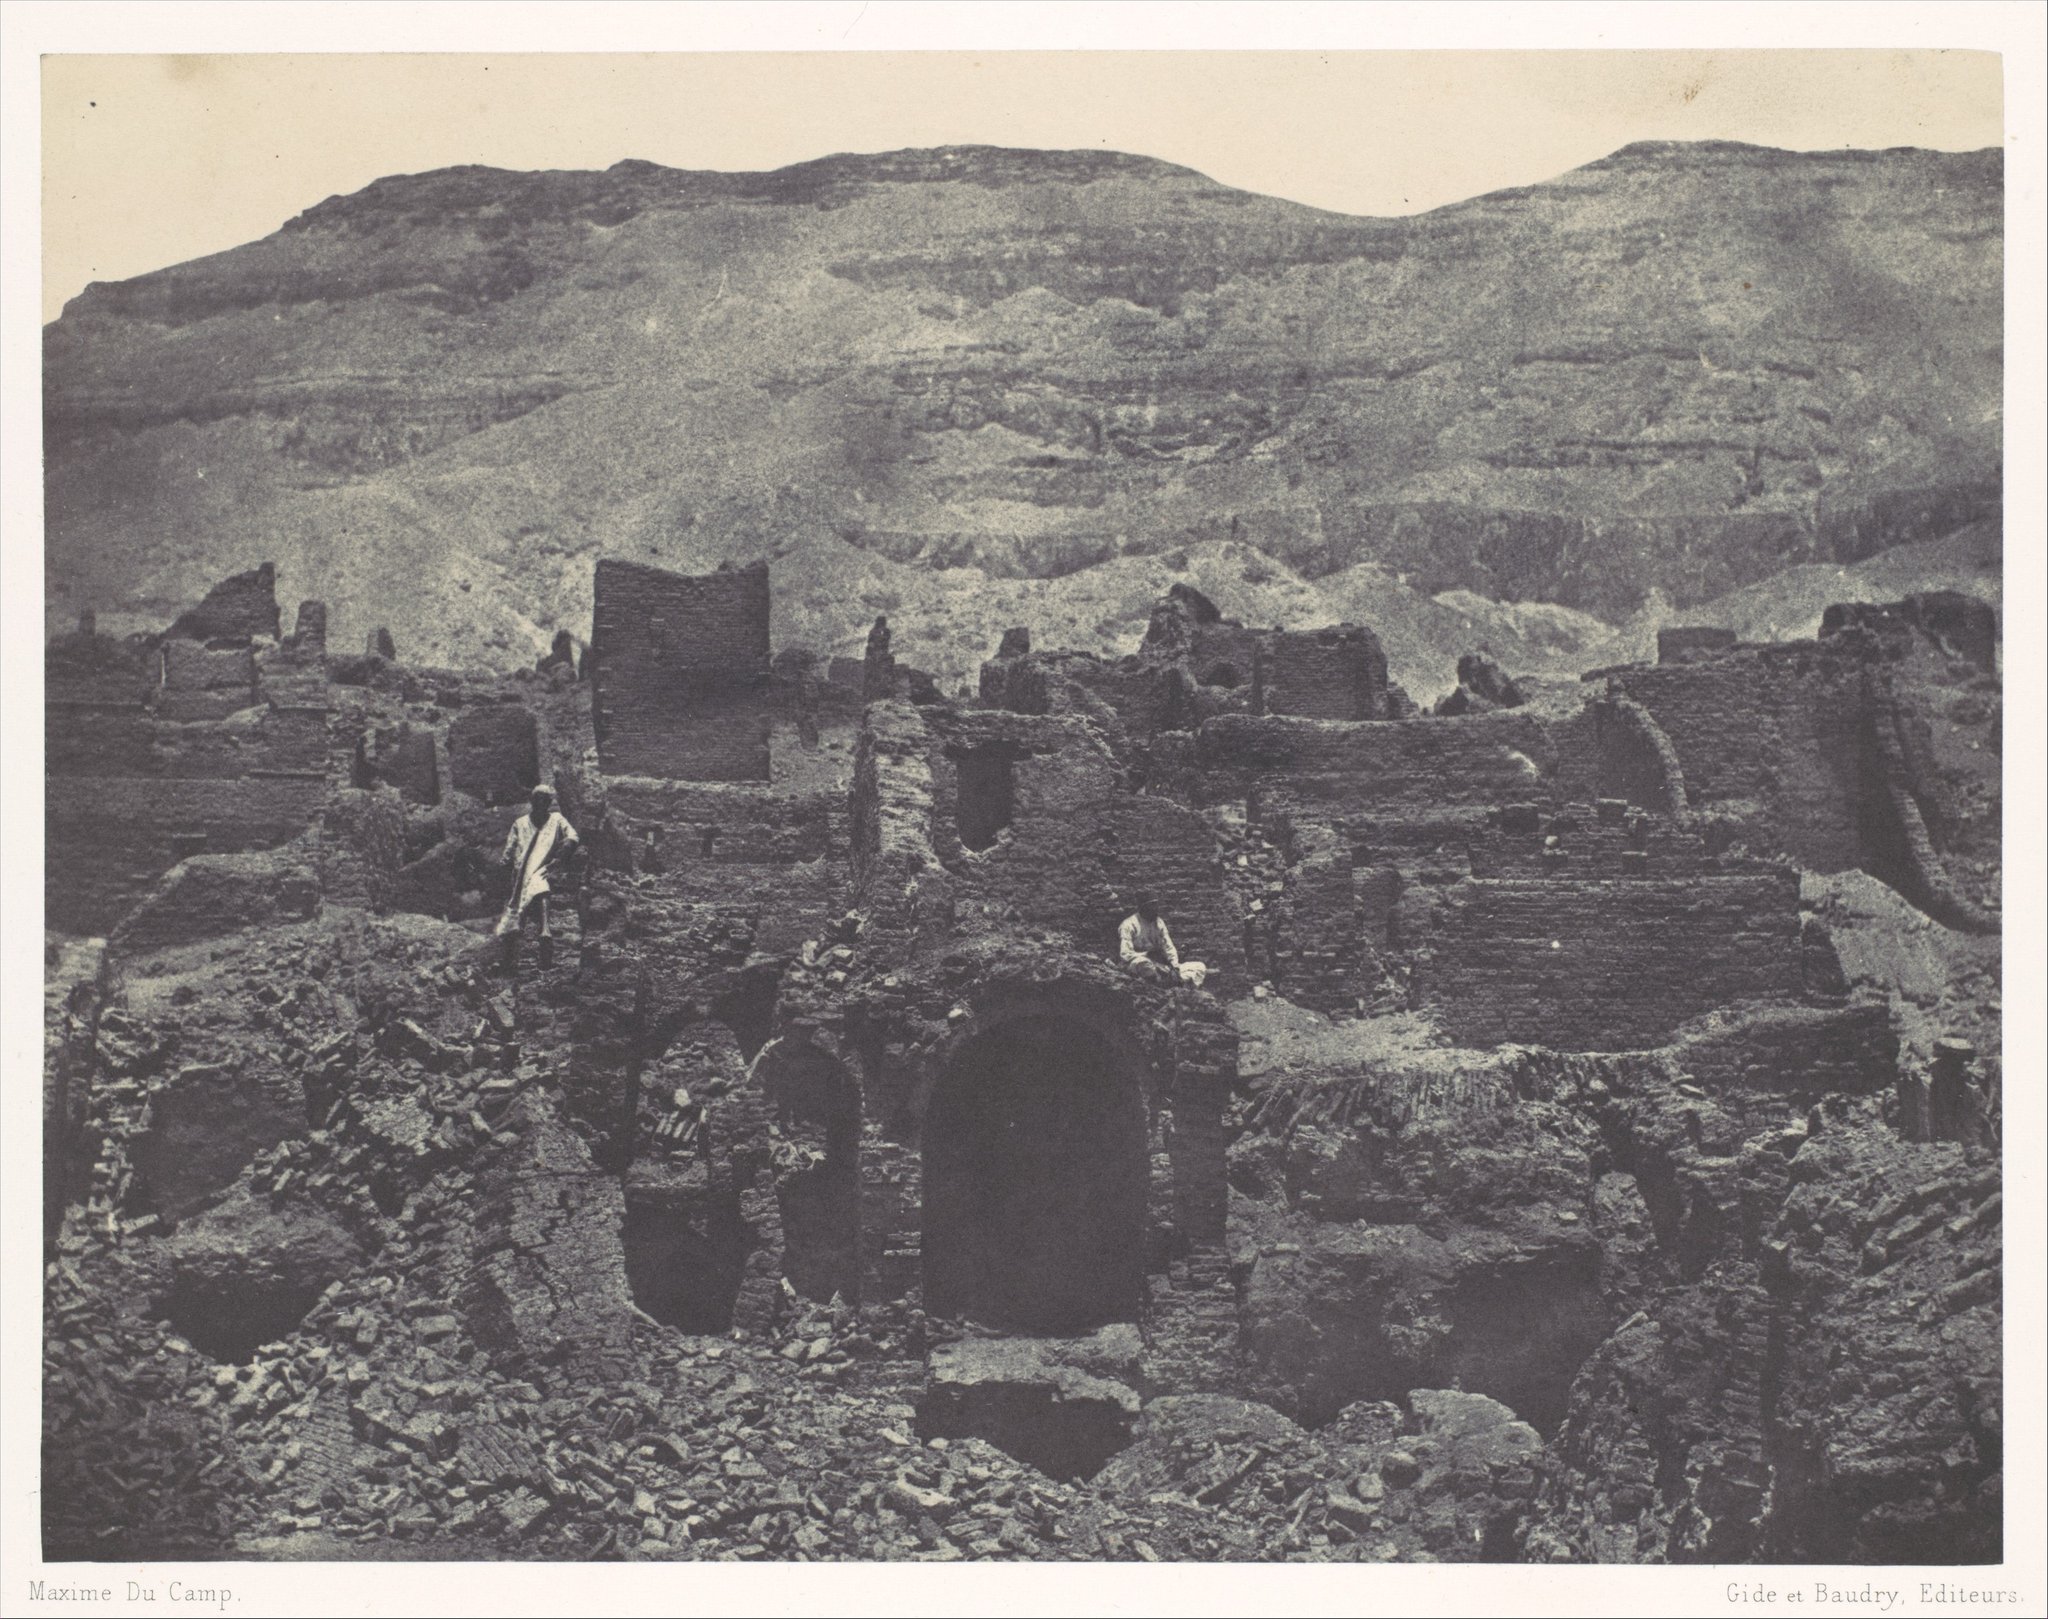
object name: photograph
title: Thebes. Médinet-Habou. Runes de la ville de Papa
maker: maxime du camp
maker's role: artist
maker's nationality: french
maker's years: 1822-1894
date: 1850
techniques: paper negative, salted paper print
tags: ruins